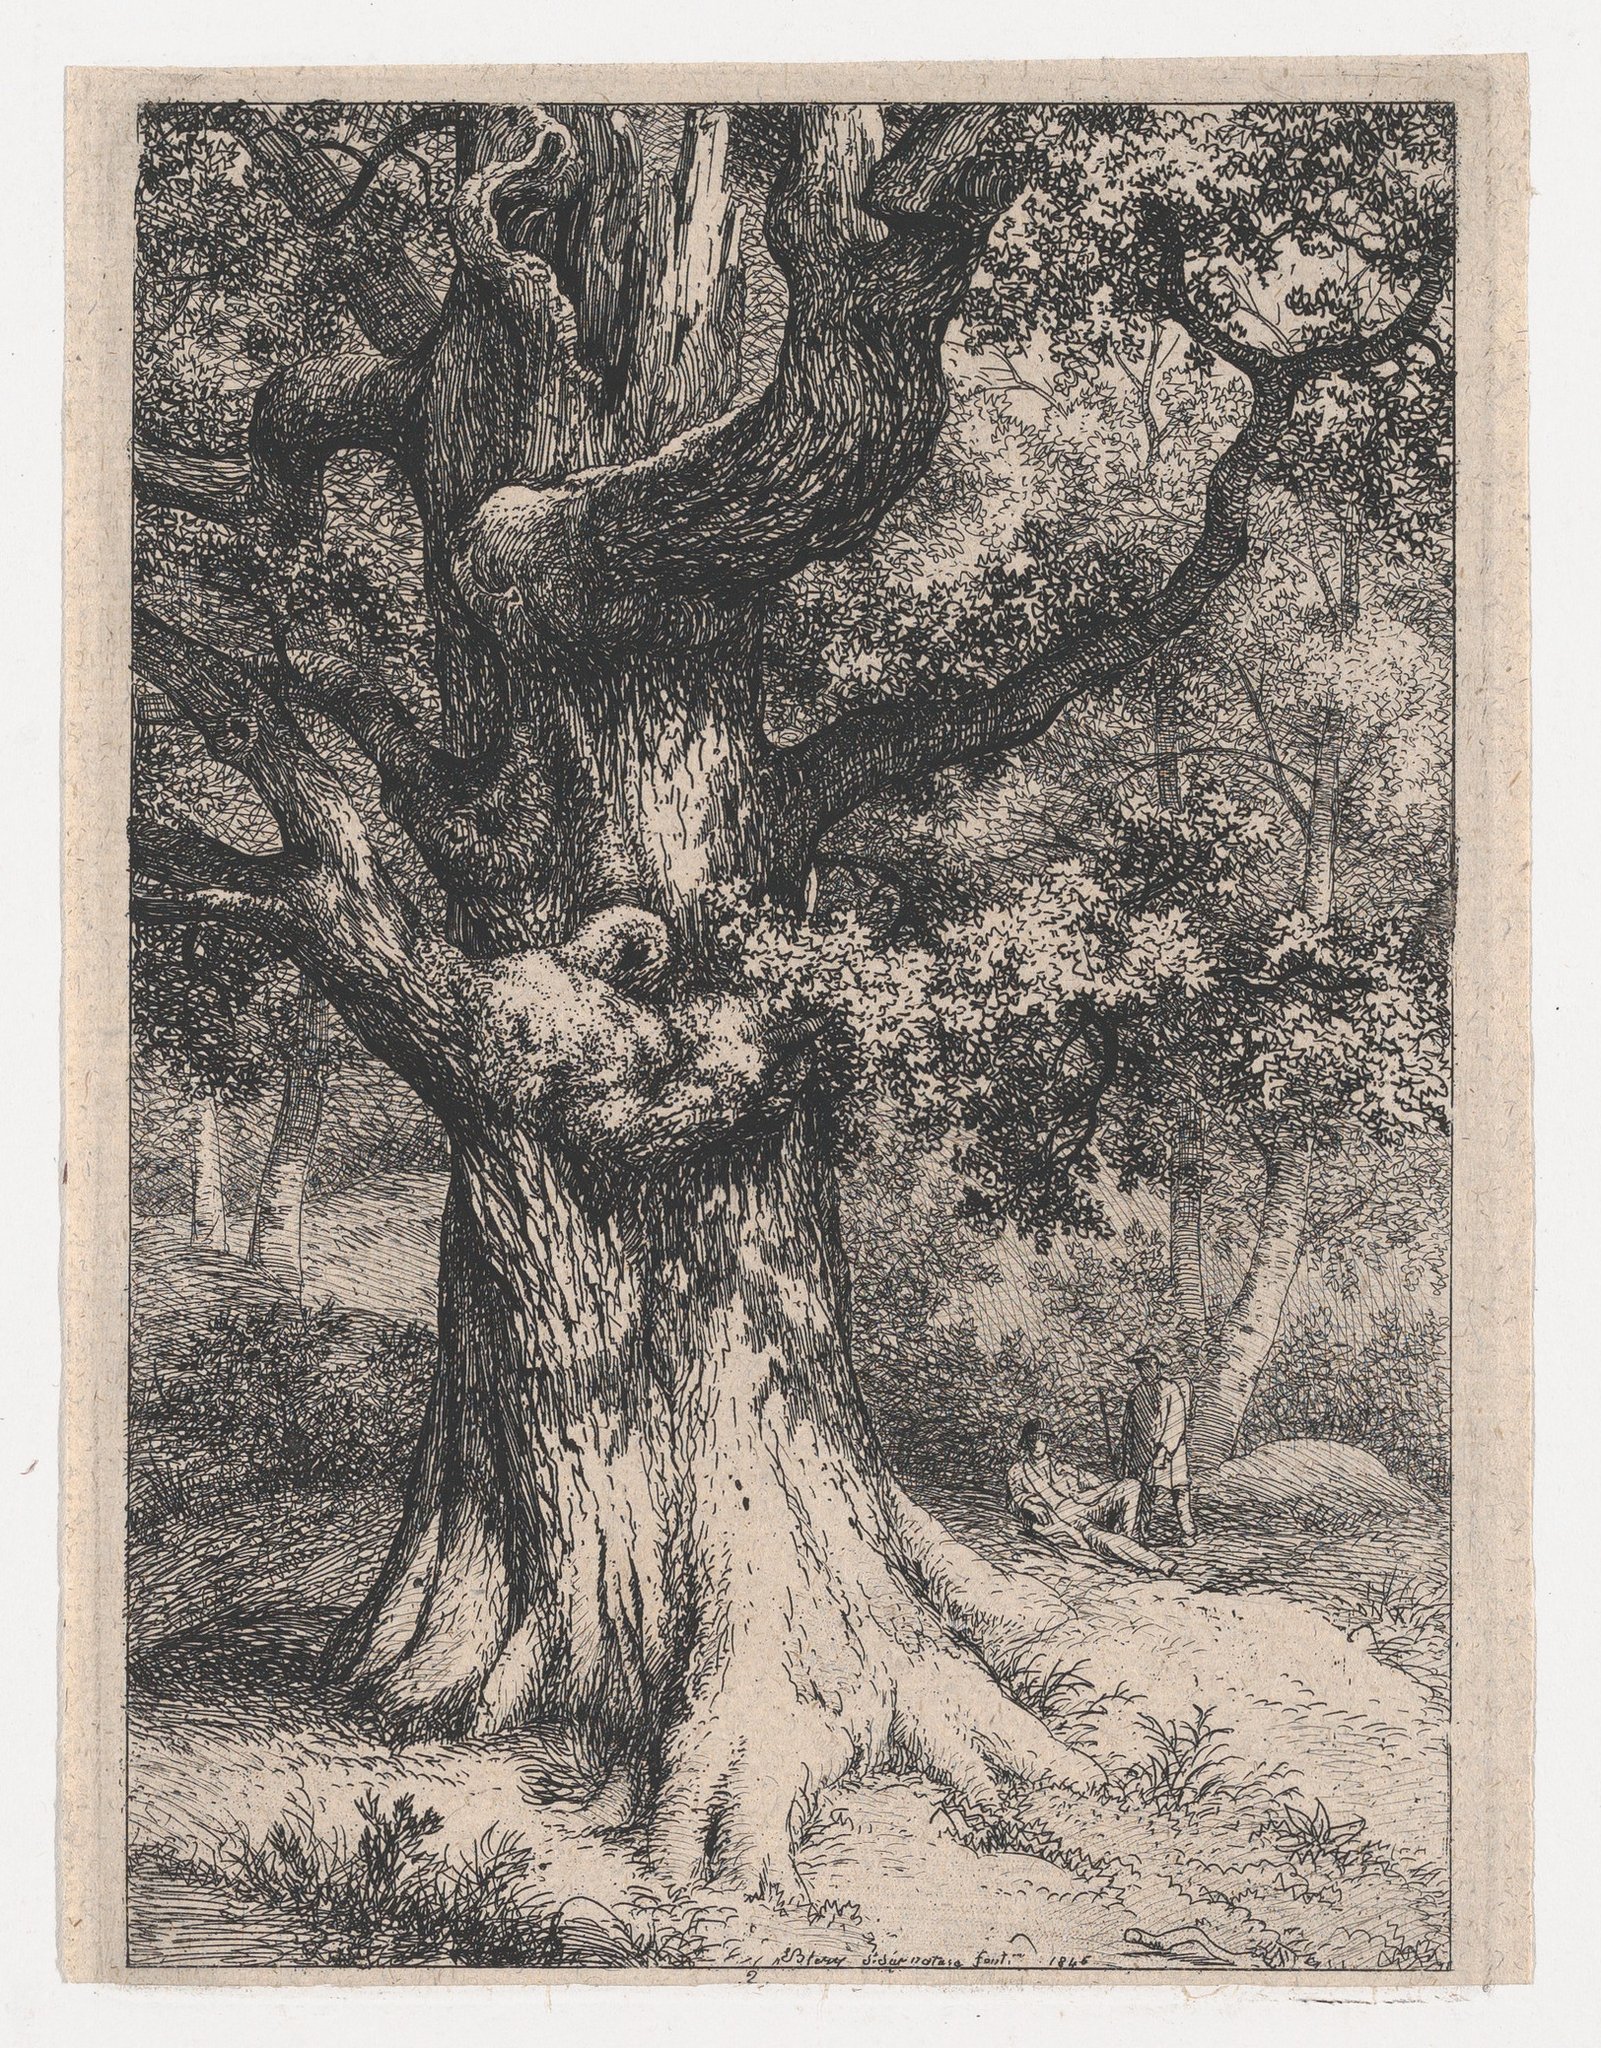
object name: print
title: The Charlemagne, Oak Tree with an Eagle's Nest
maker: eugène bléry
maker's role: artist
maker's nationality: french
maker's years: 1805-1887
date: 1845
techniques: etching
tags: men,oaks